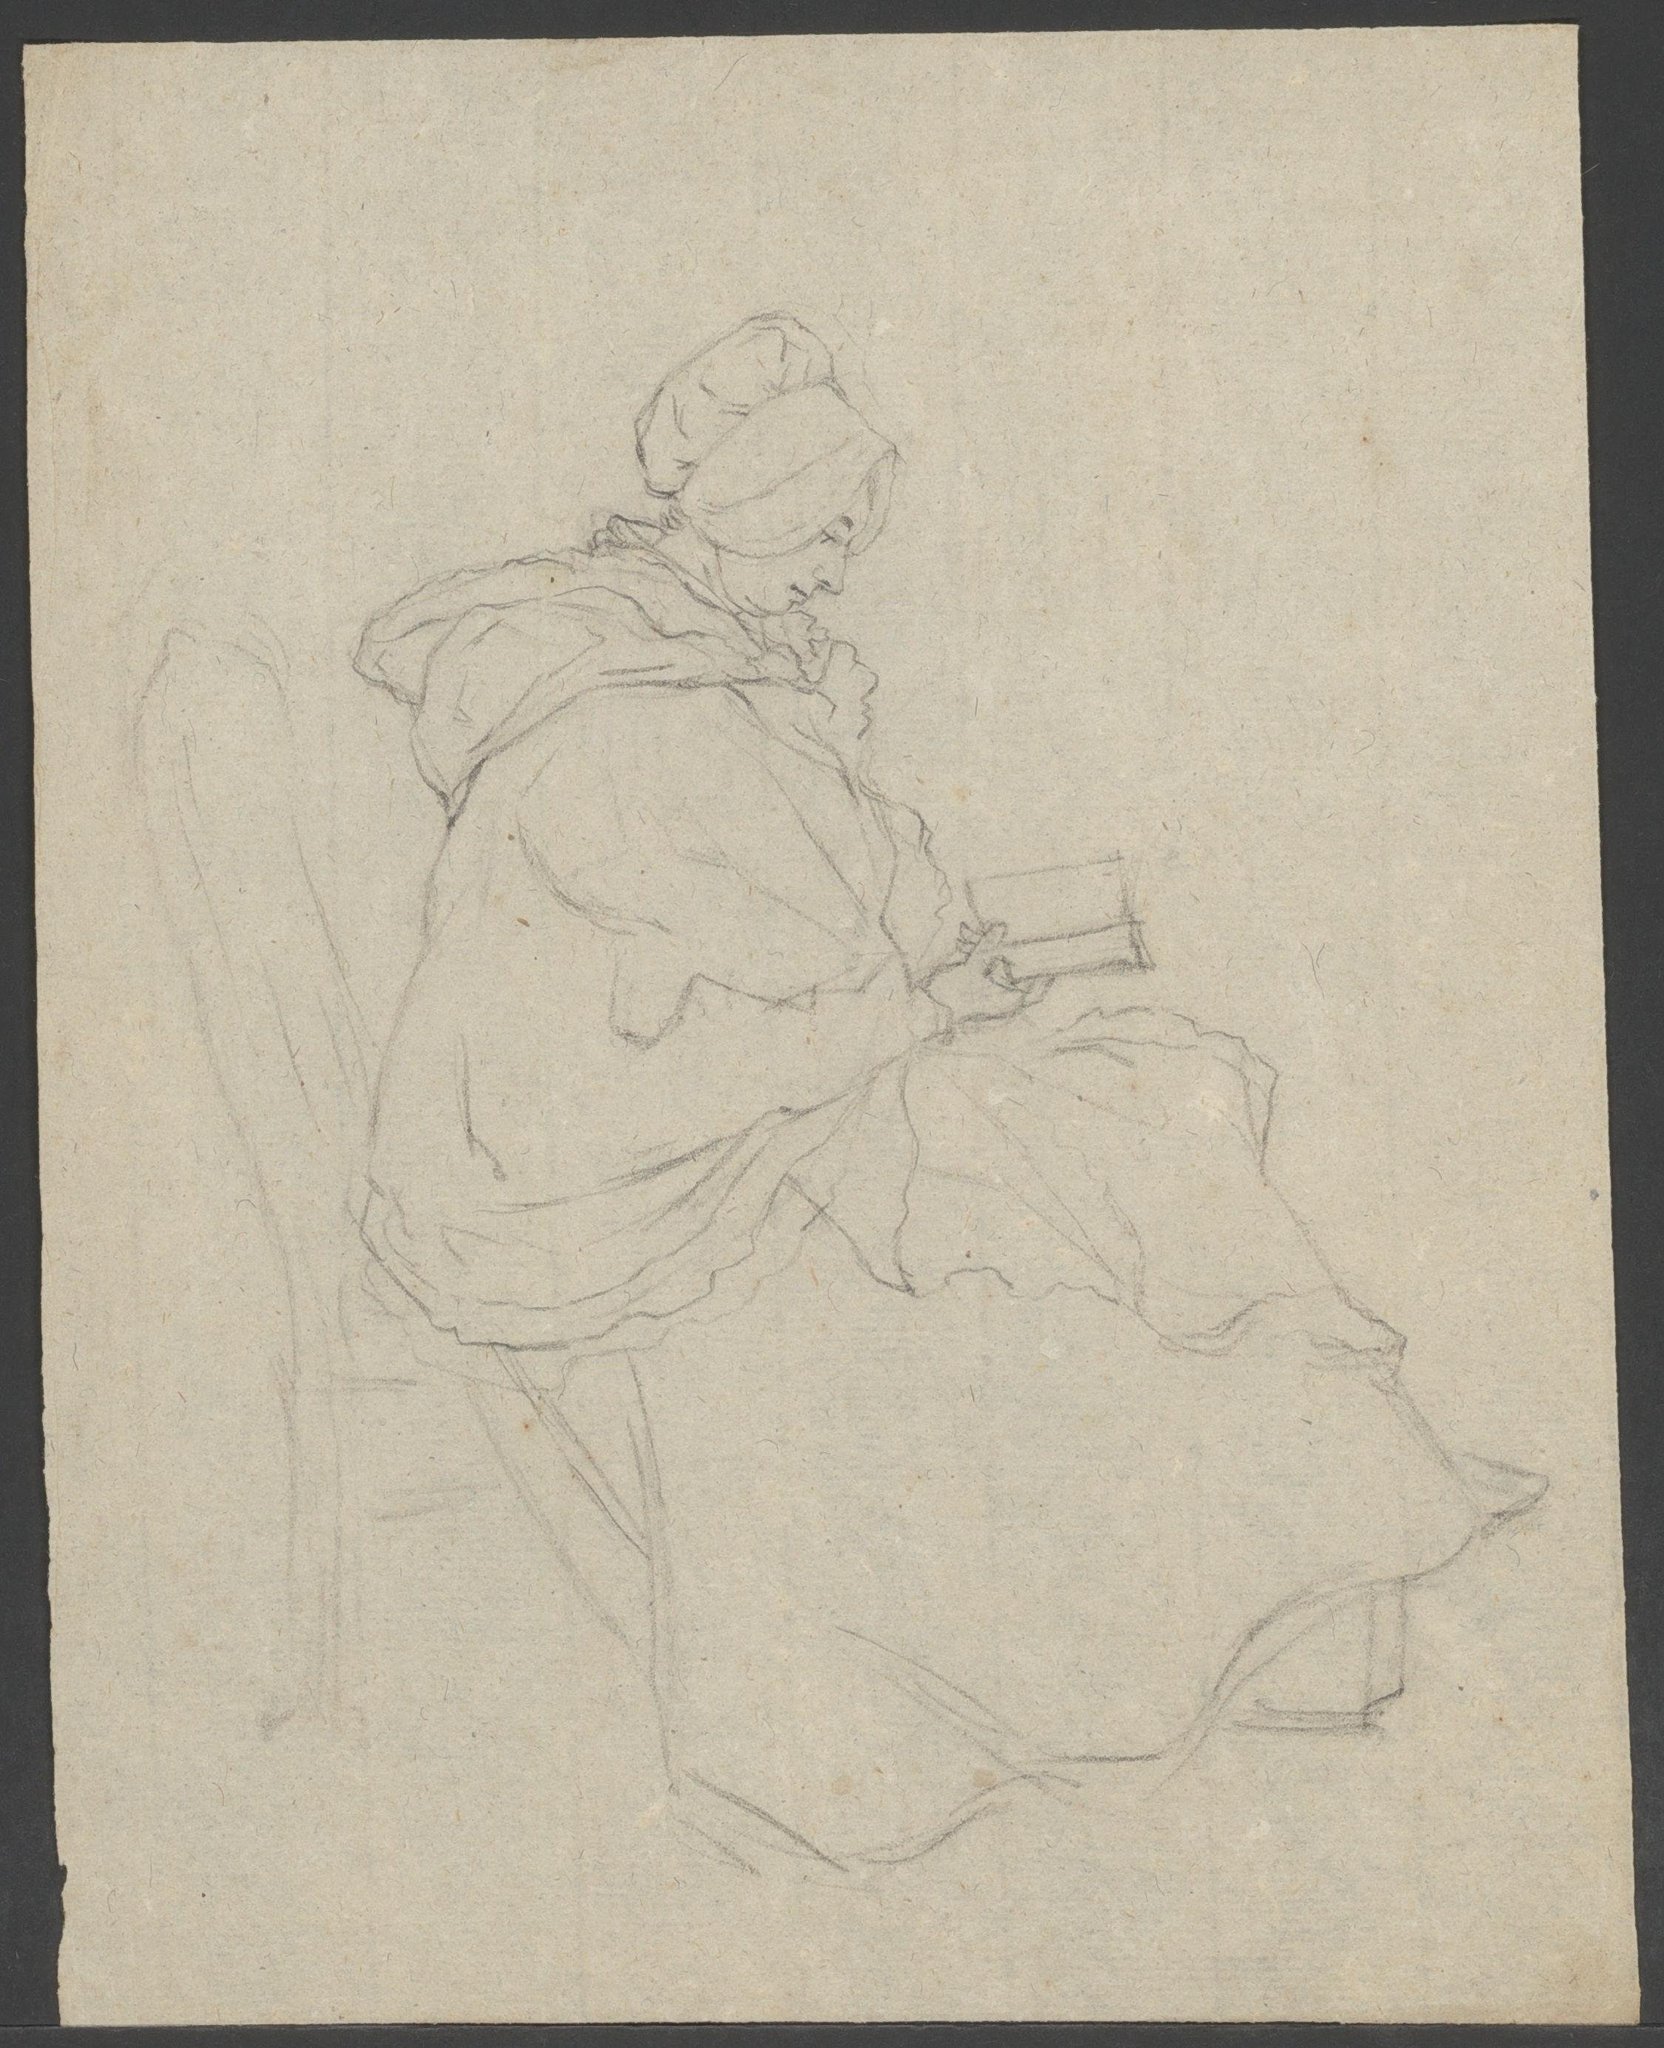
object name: drawing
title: Lezende vrouw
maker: Anonymous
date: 1800-1899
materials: chalk, paper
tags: reading, sitting figure - aa - female human figure, chair, sitting on an elevation - aa - female human figure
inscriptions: collector's mark: Lugt 1641, stamp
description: Een vrouw zit op een stoel te lezen. Ze draagt een muts. Onderwerpsrubrieken binnen de Atlas Zeden en Gewoonten: Schoone kunsten, Schilderkunst, Tekeningen.